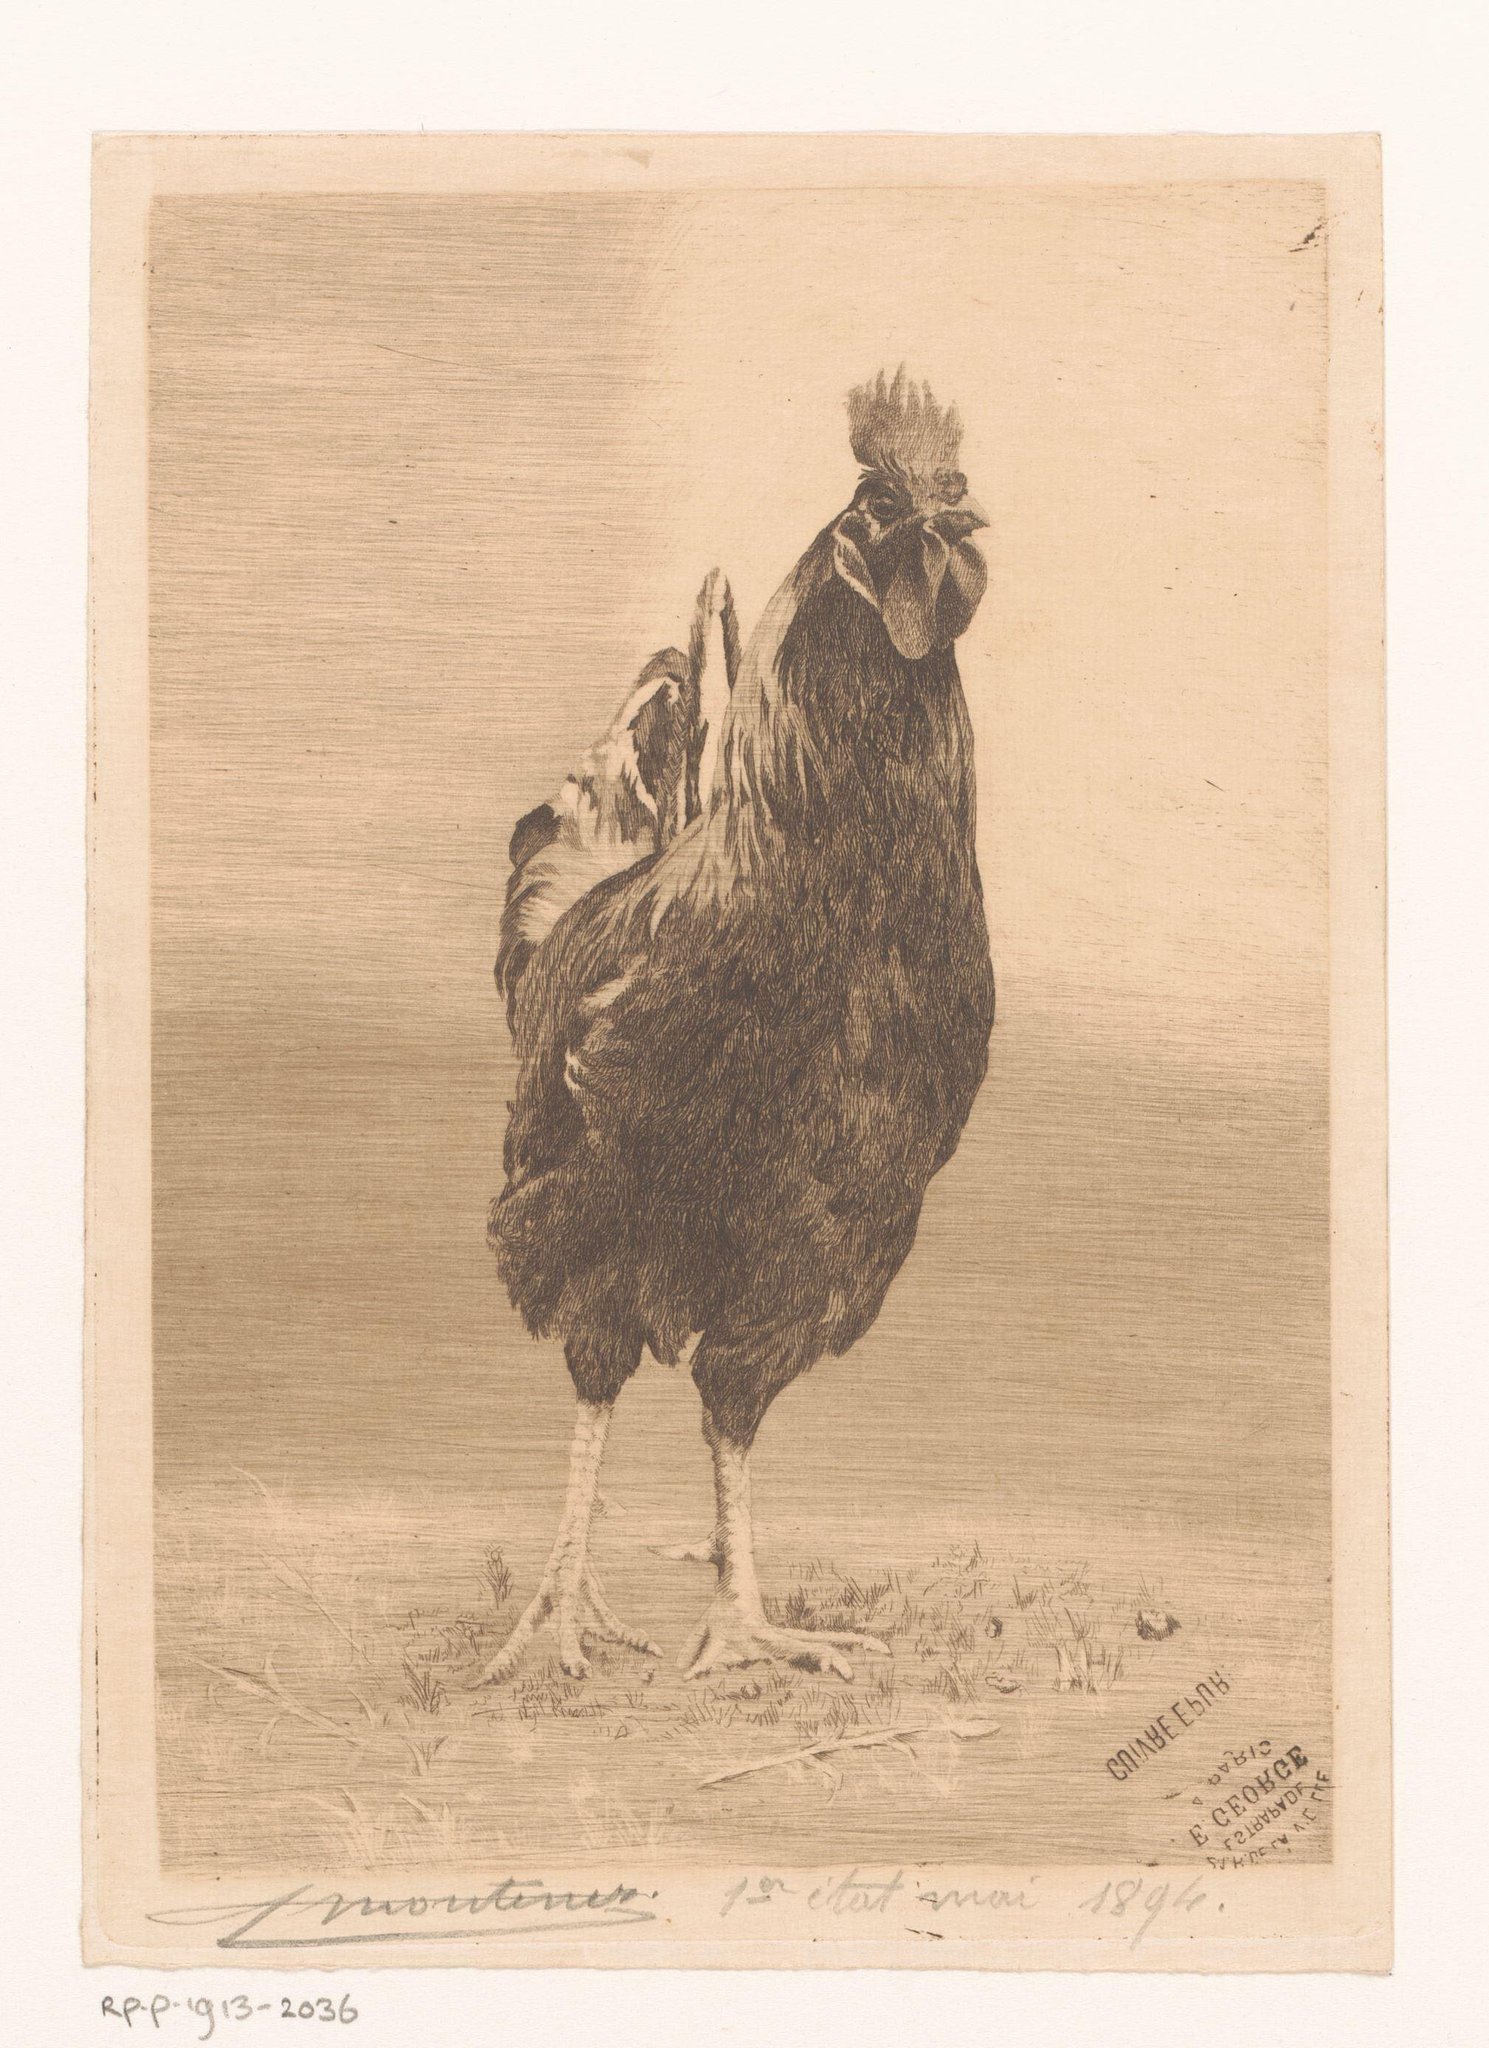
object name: print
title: Haan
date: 1894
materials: paper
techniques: etching, intaglio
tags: fowl (cock, hen, chicken, etc.)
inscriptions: collector's mark: Lugt 2228, inscription: ‘1e état moi 1894’, mark: ‘Cuivre epur; a Paris, E. George, estrapade [...]’